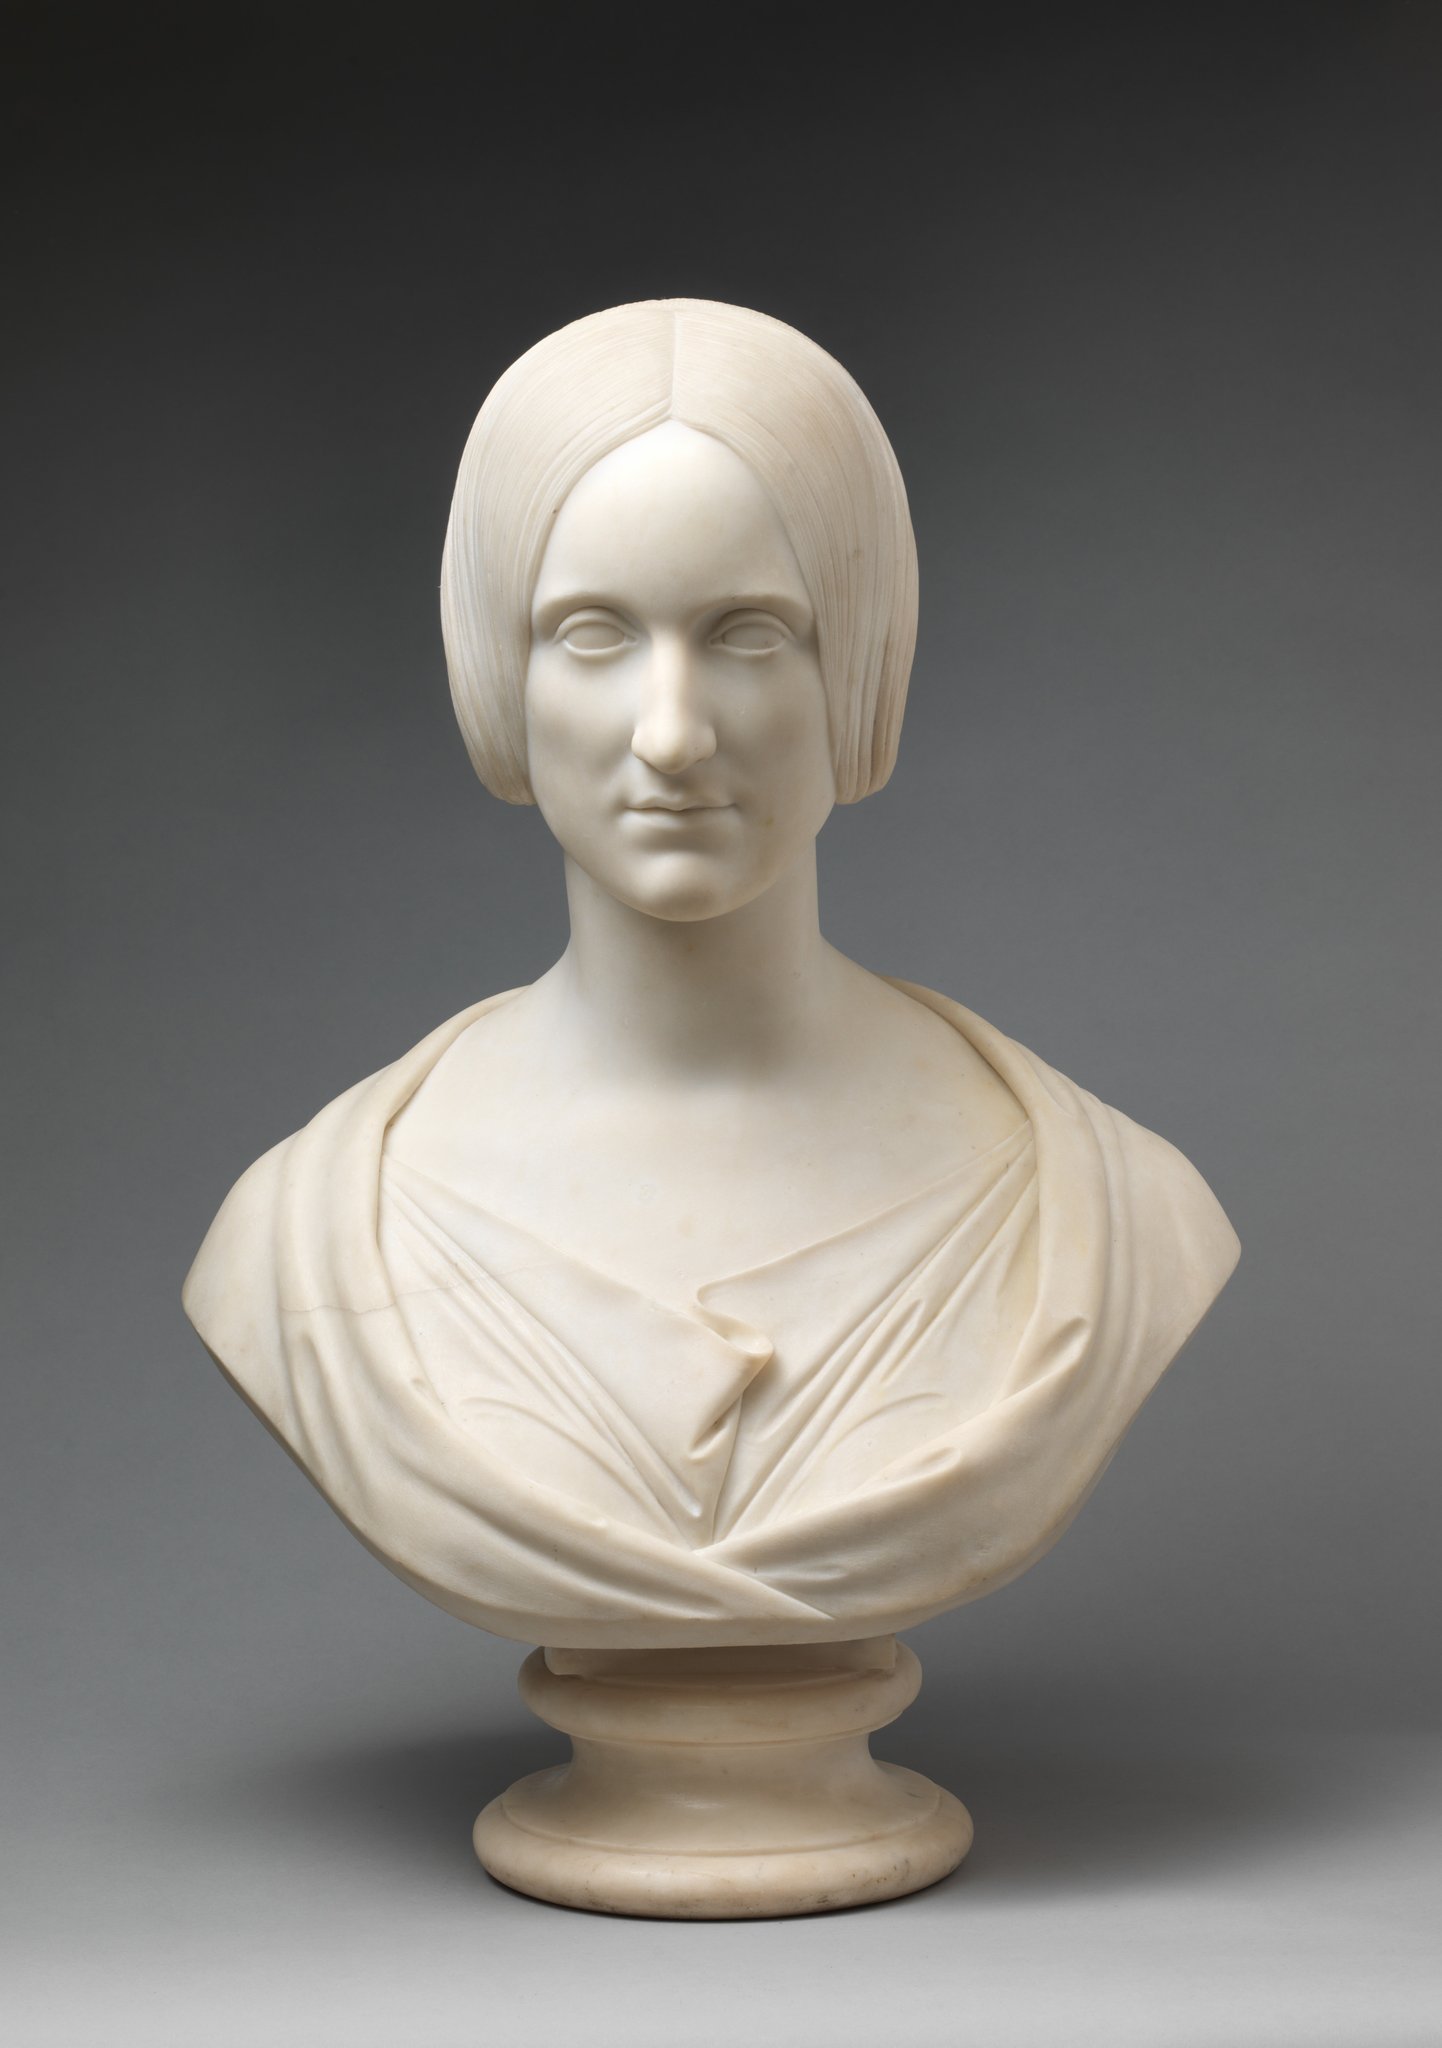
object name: bust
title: Mary Shelley (1797–1851)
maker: camillo pistrucci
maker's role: artist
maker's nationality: british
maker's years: 1811-1854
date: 1843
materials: marble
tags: portraits,women